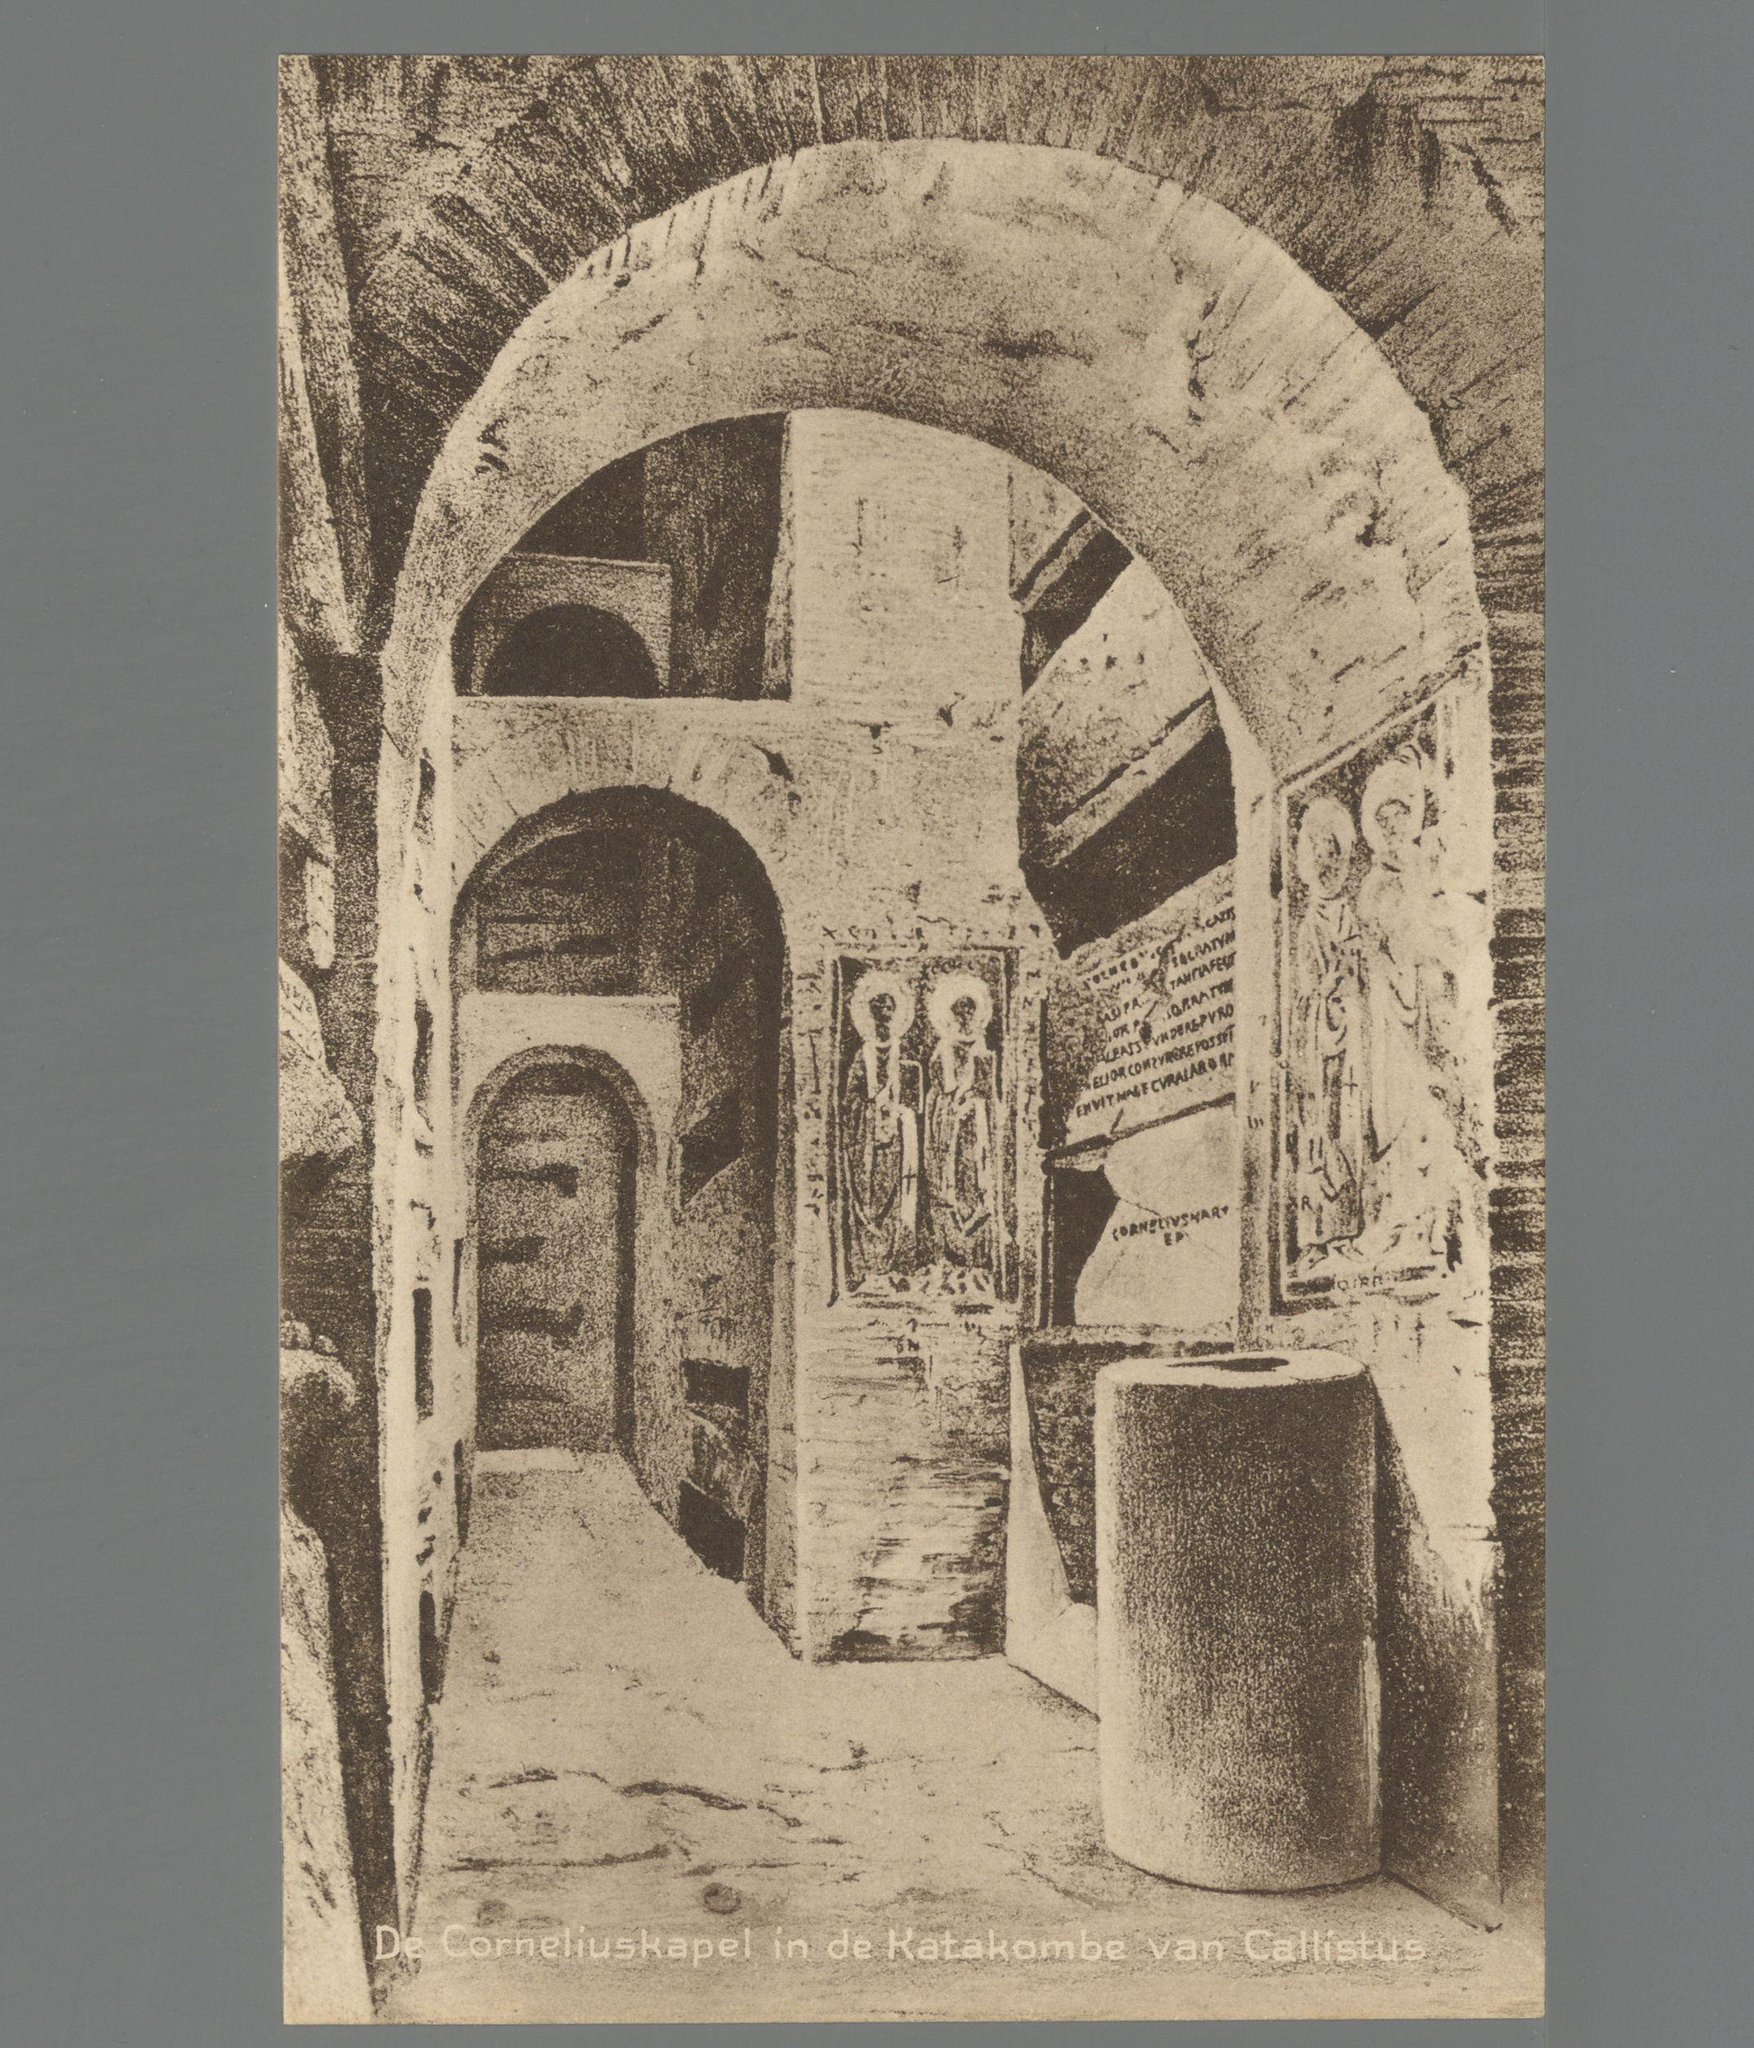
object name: photomechanical print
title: De Corneliuskapel in de Katakombe van Callistus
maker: Anonymous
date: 1929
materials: cardboard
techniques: photograph, writing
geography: valkenburg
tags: interior ~ representation of a building, catacombs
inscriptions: mark: ‘ZN’